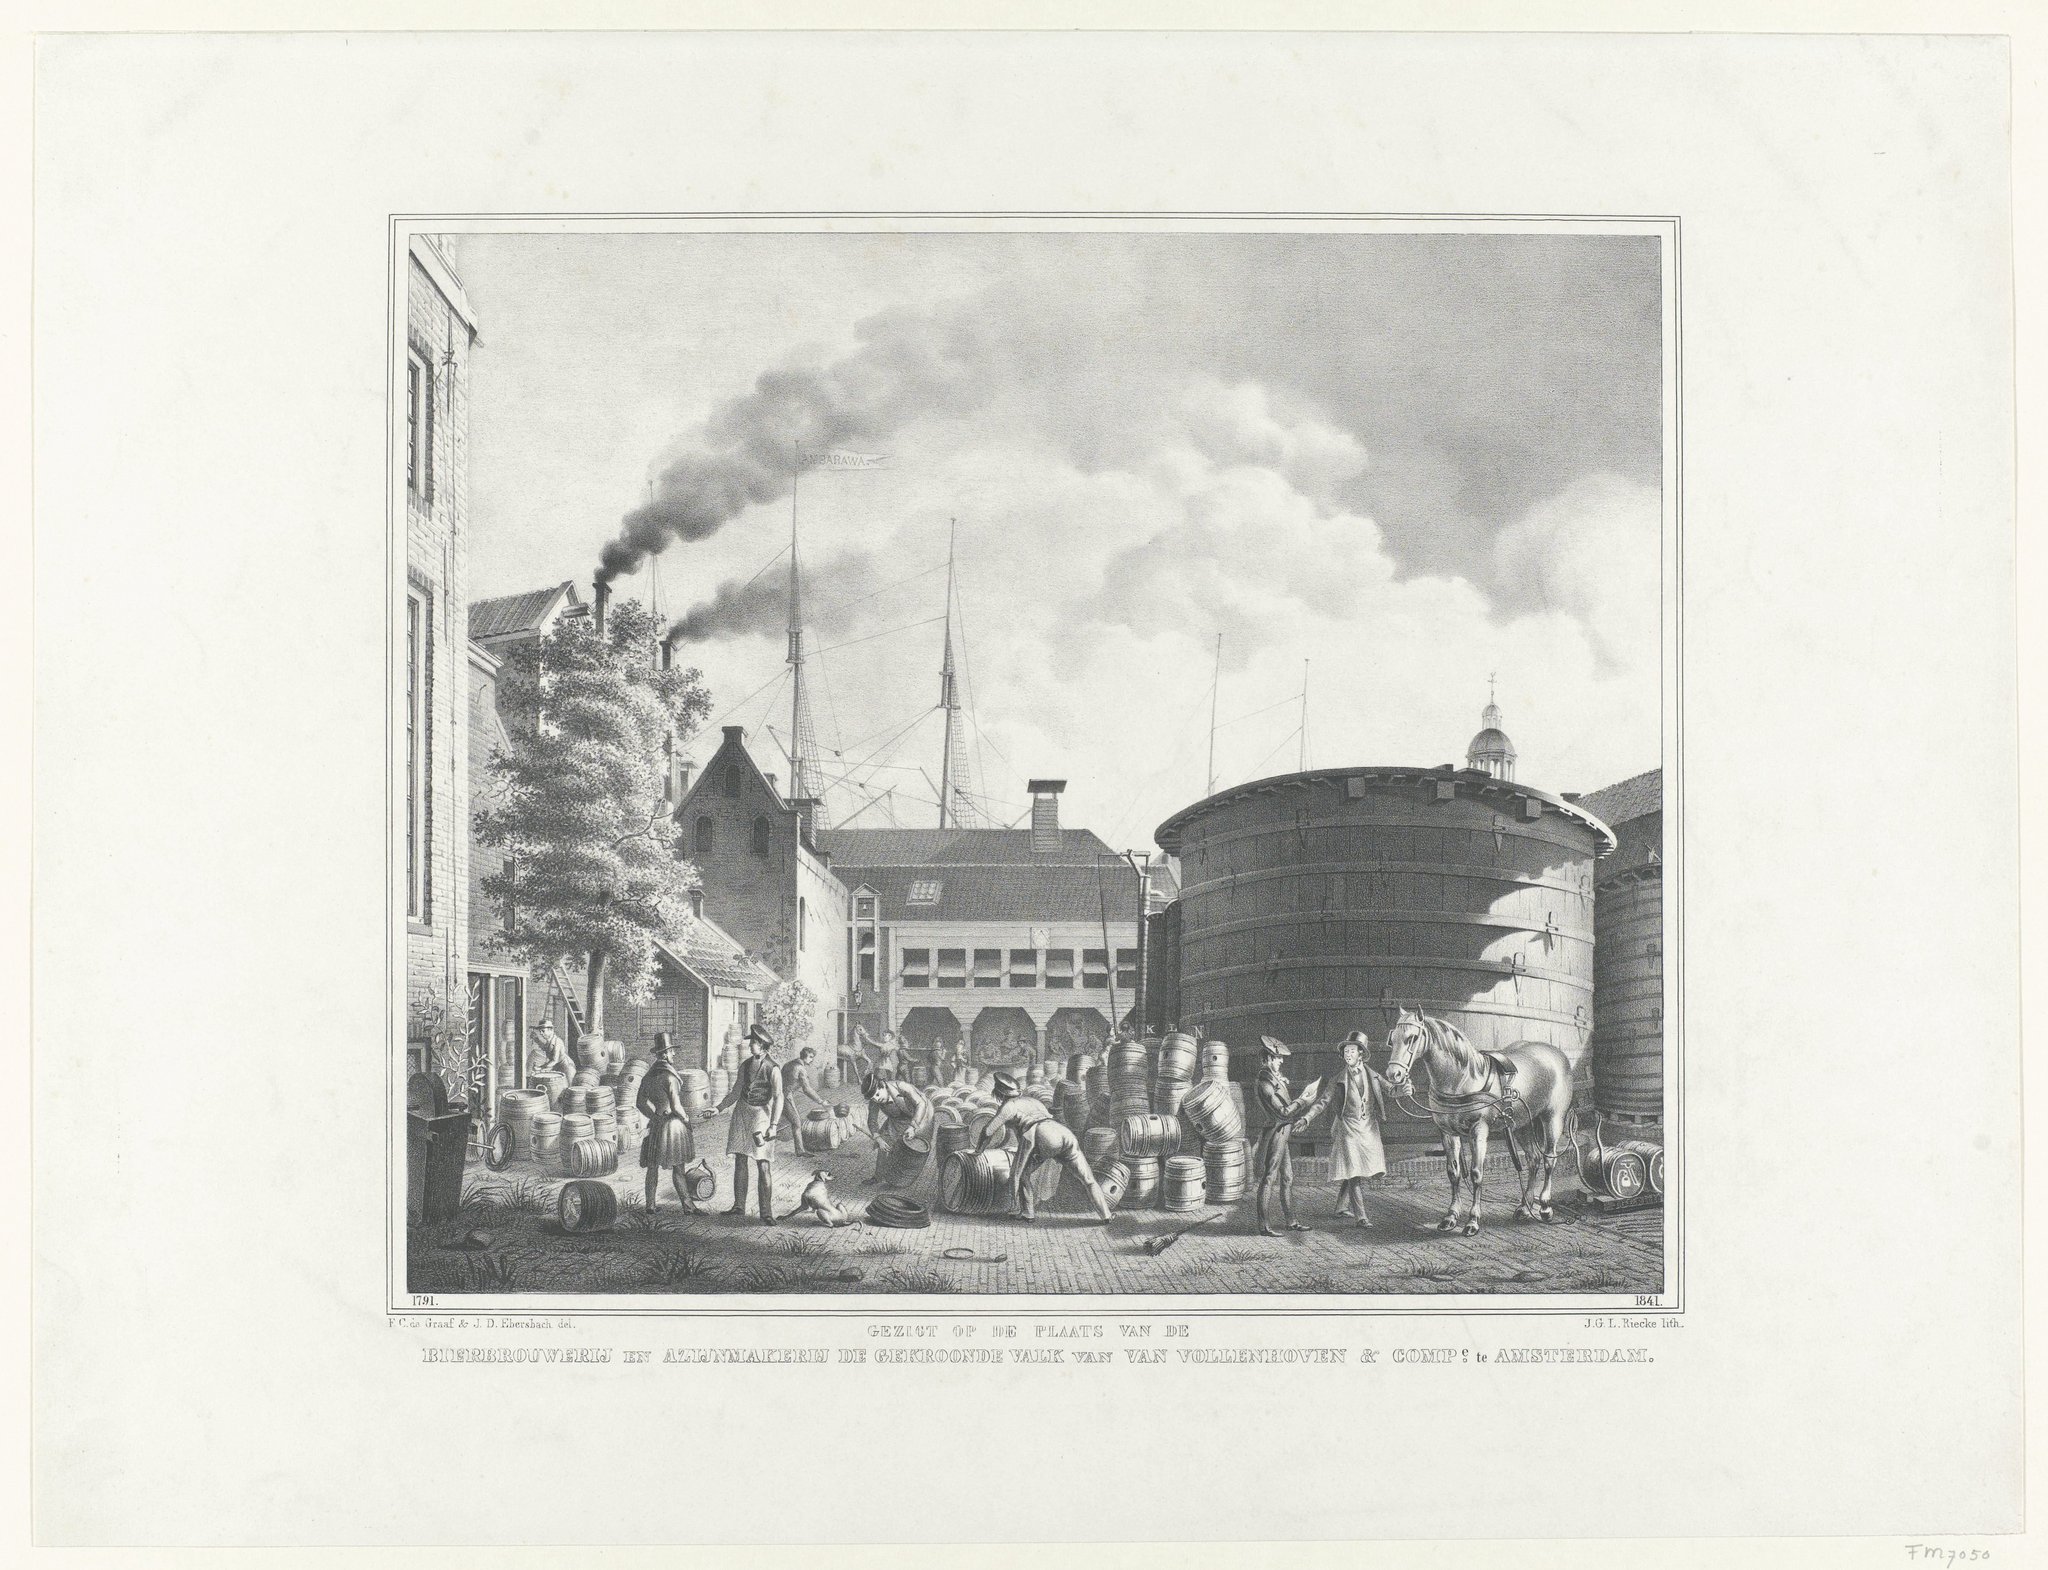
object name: print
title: Bierbrouwerij en Azijnmakerij de Gekroonde Valk te Amsterdam, 1841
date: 1841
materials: paper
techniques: lithograph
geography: amsterdam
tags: brewer, vinegar, amsterdam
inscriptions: collector's mark: Lugt 2228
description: Gezicht op de binnenplaats van bierbrouwerij en azijnmakerij De Gekroonde Valk, Hoogte Kadijk 75 van de firma Van Vollenhove & Comp. Ter gelegenheid van het vijftigjarig bestaan van het bedrijf, 1791-1841.